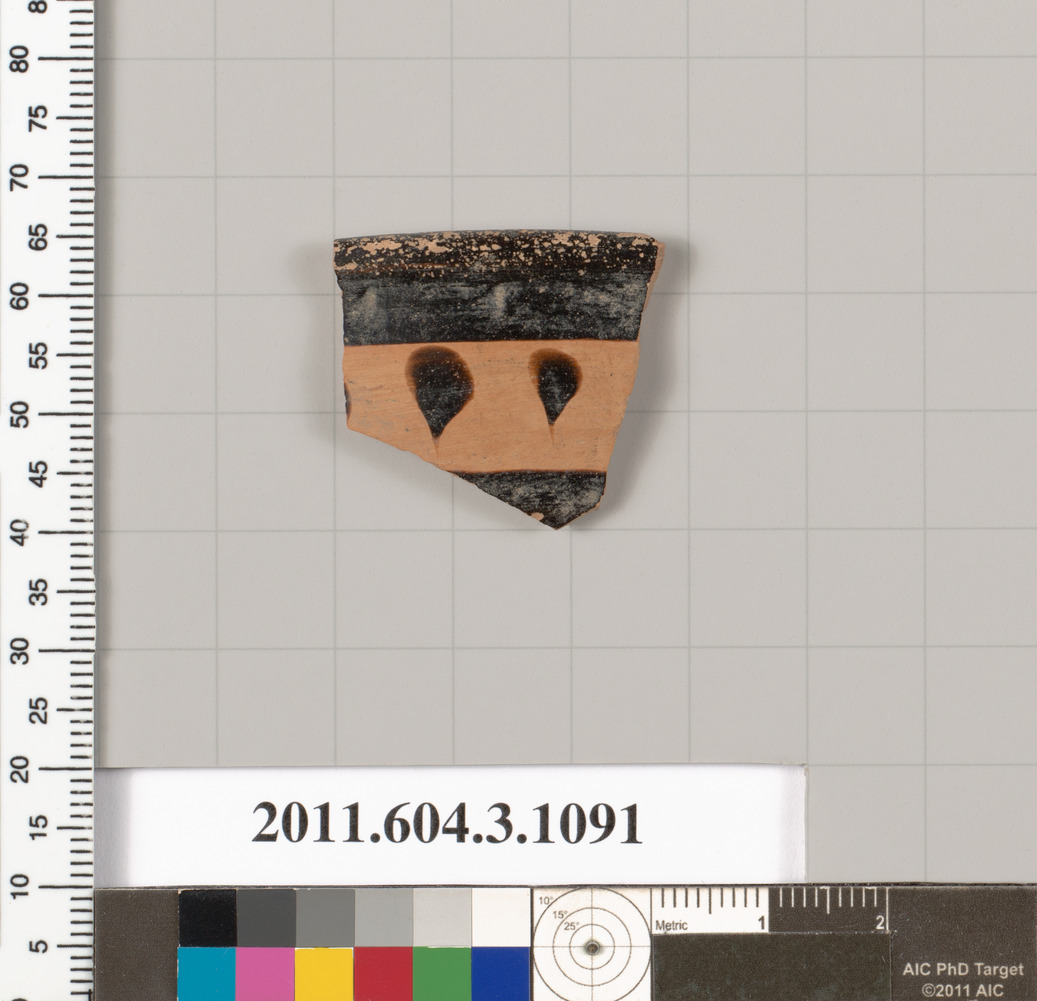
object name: mastoid fragment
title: Terracotta rim fragment of a mastoid (drinking cup with narrow base)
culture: greek, attic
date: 534-468 BCE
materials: terracotta